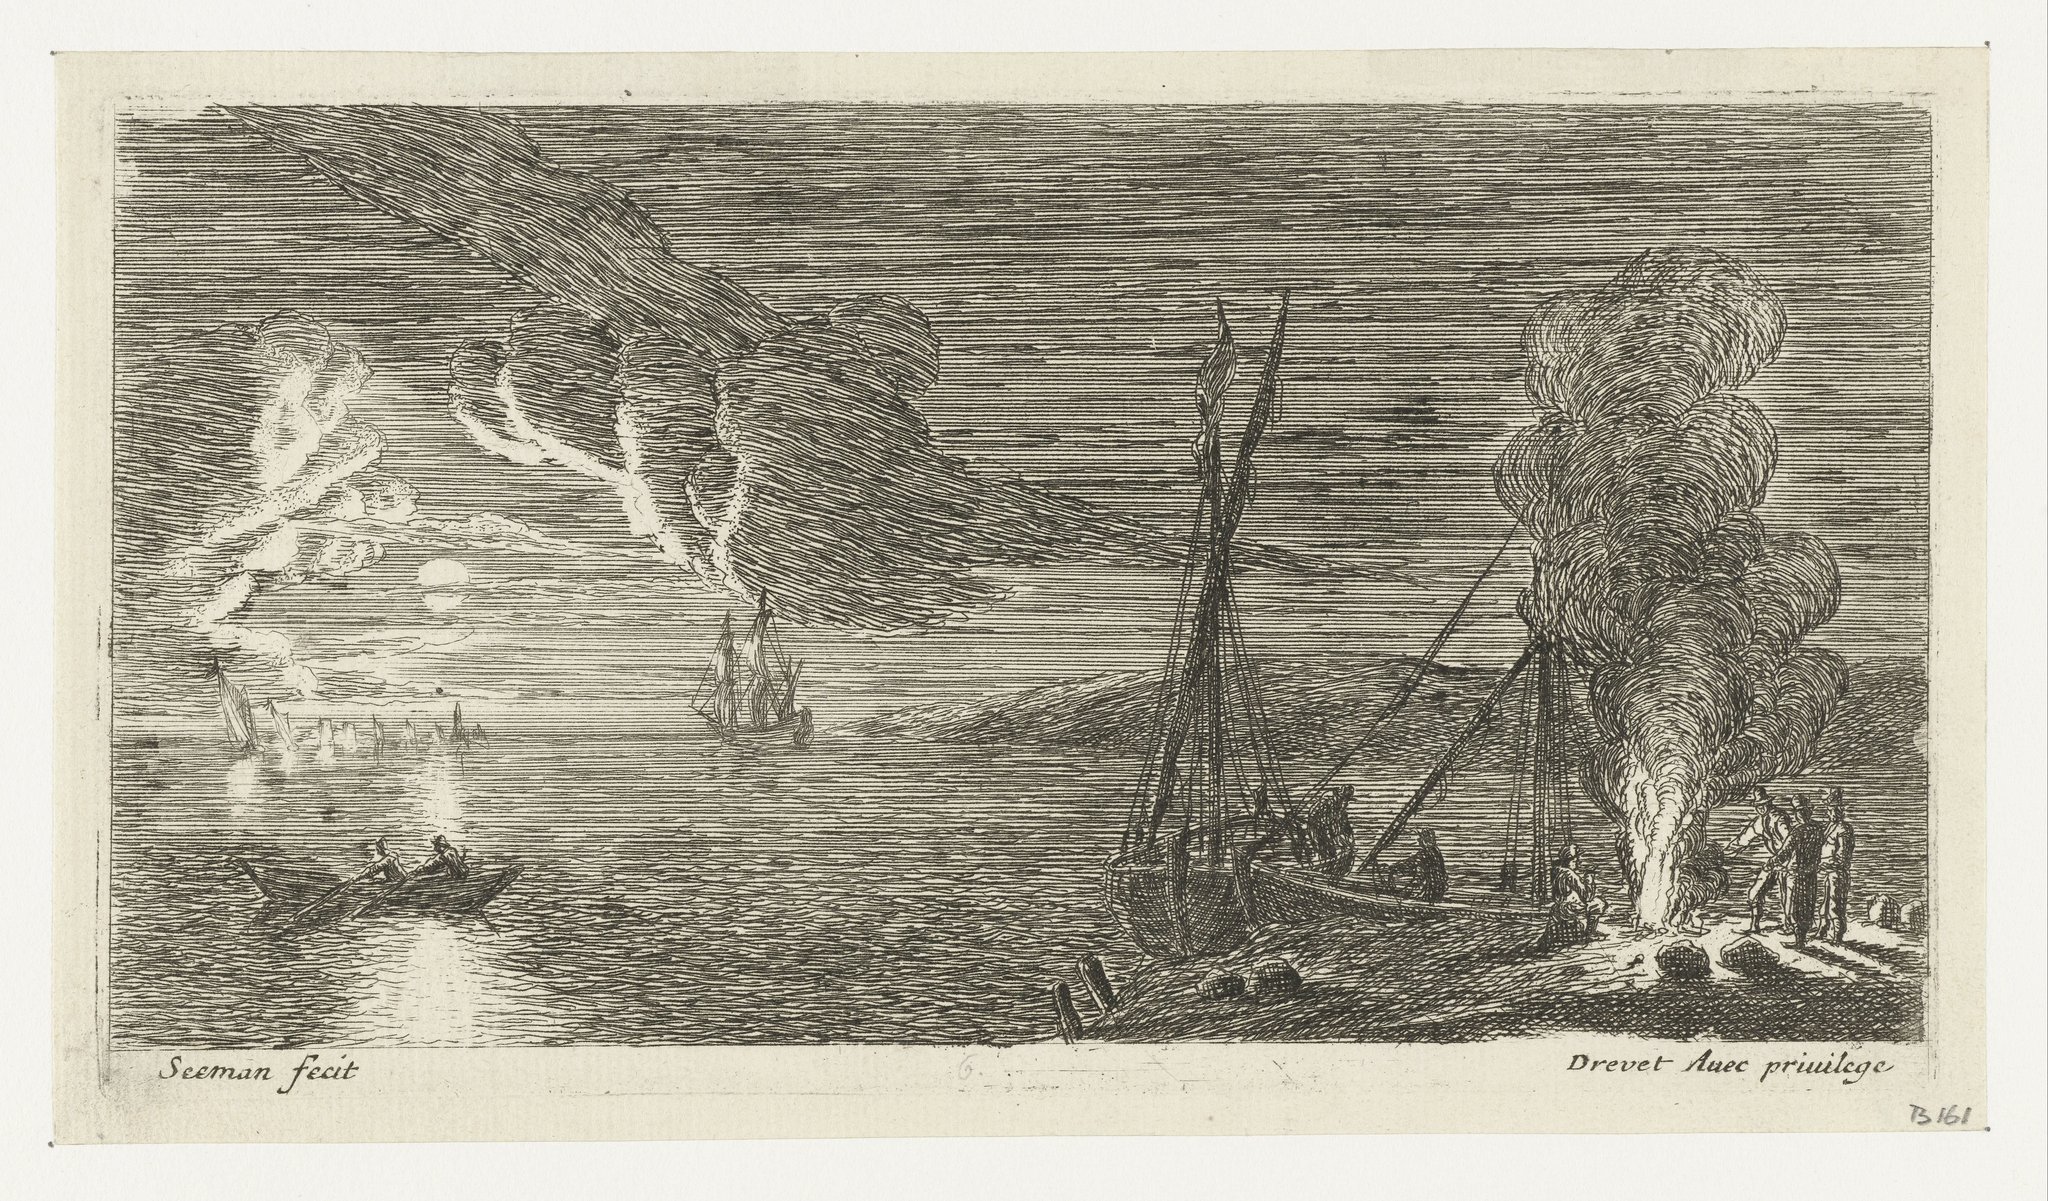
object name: print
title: Verschillende zeegezichten en landschappen.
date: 1650-1738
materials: paper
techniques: etching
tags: camp-fire; watch-fire, night, fisherman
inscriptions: collector's mark: Lugt 2228a, collector's mark: Lugt 1020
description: Vissers op de kade rondom een vuur. In het water een roeiboot en een aantal zeilschepen bij maanlicht.